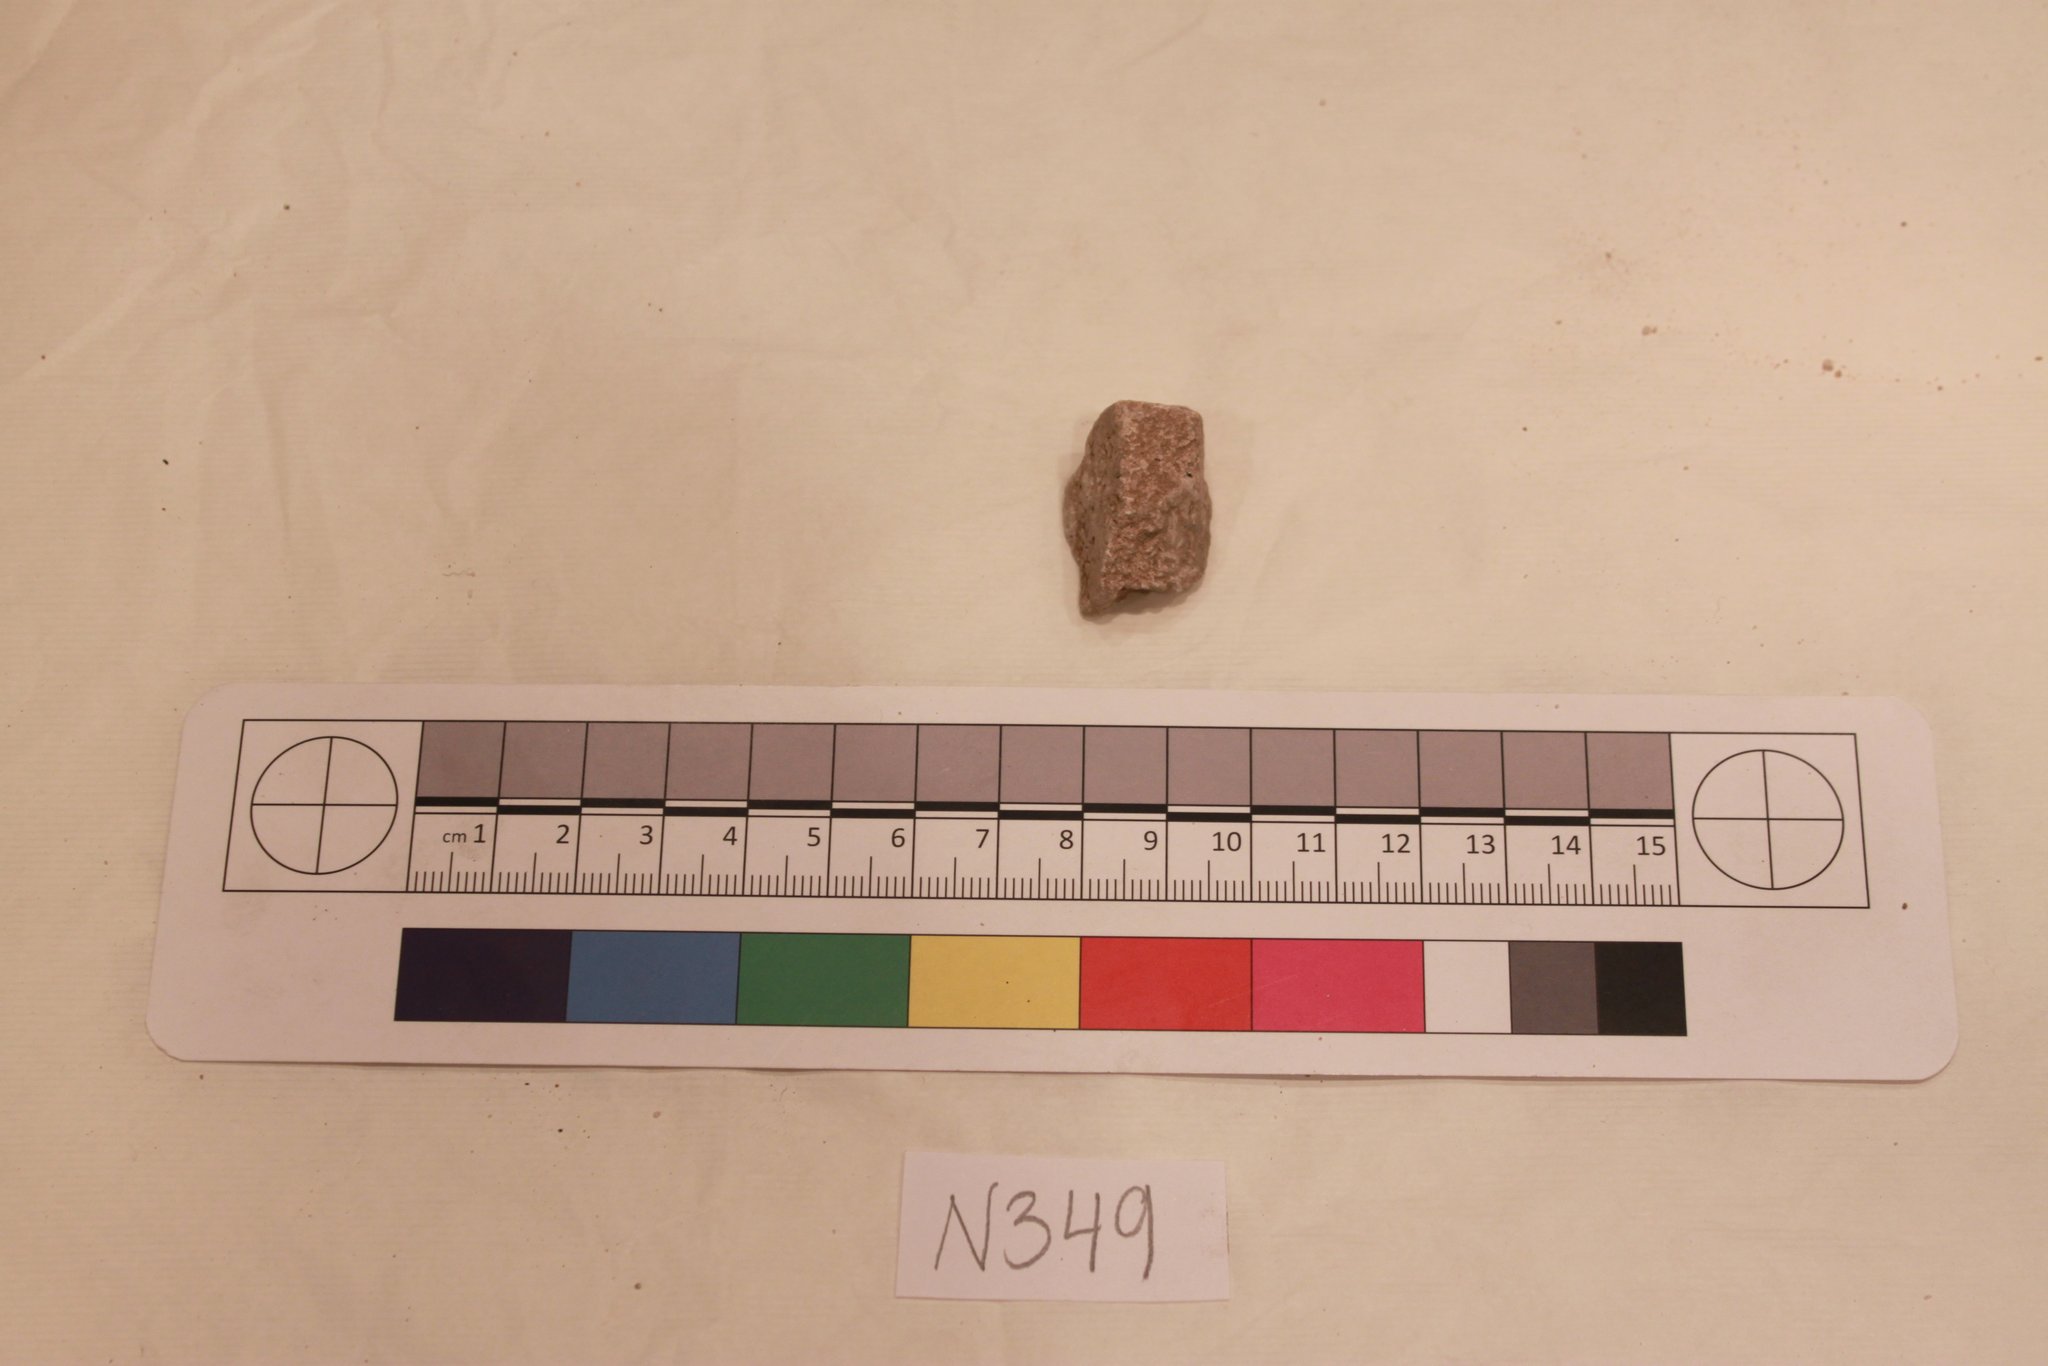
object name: fragment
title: Stucco Fragment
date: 701-1200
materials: plaster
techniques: carving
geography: iran